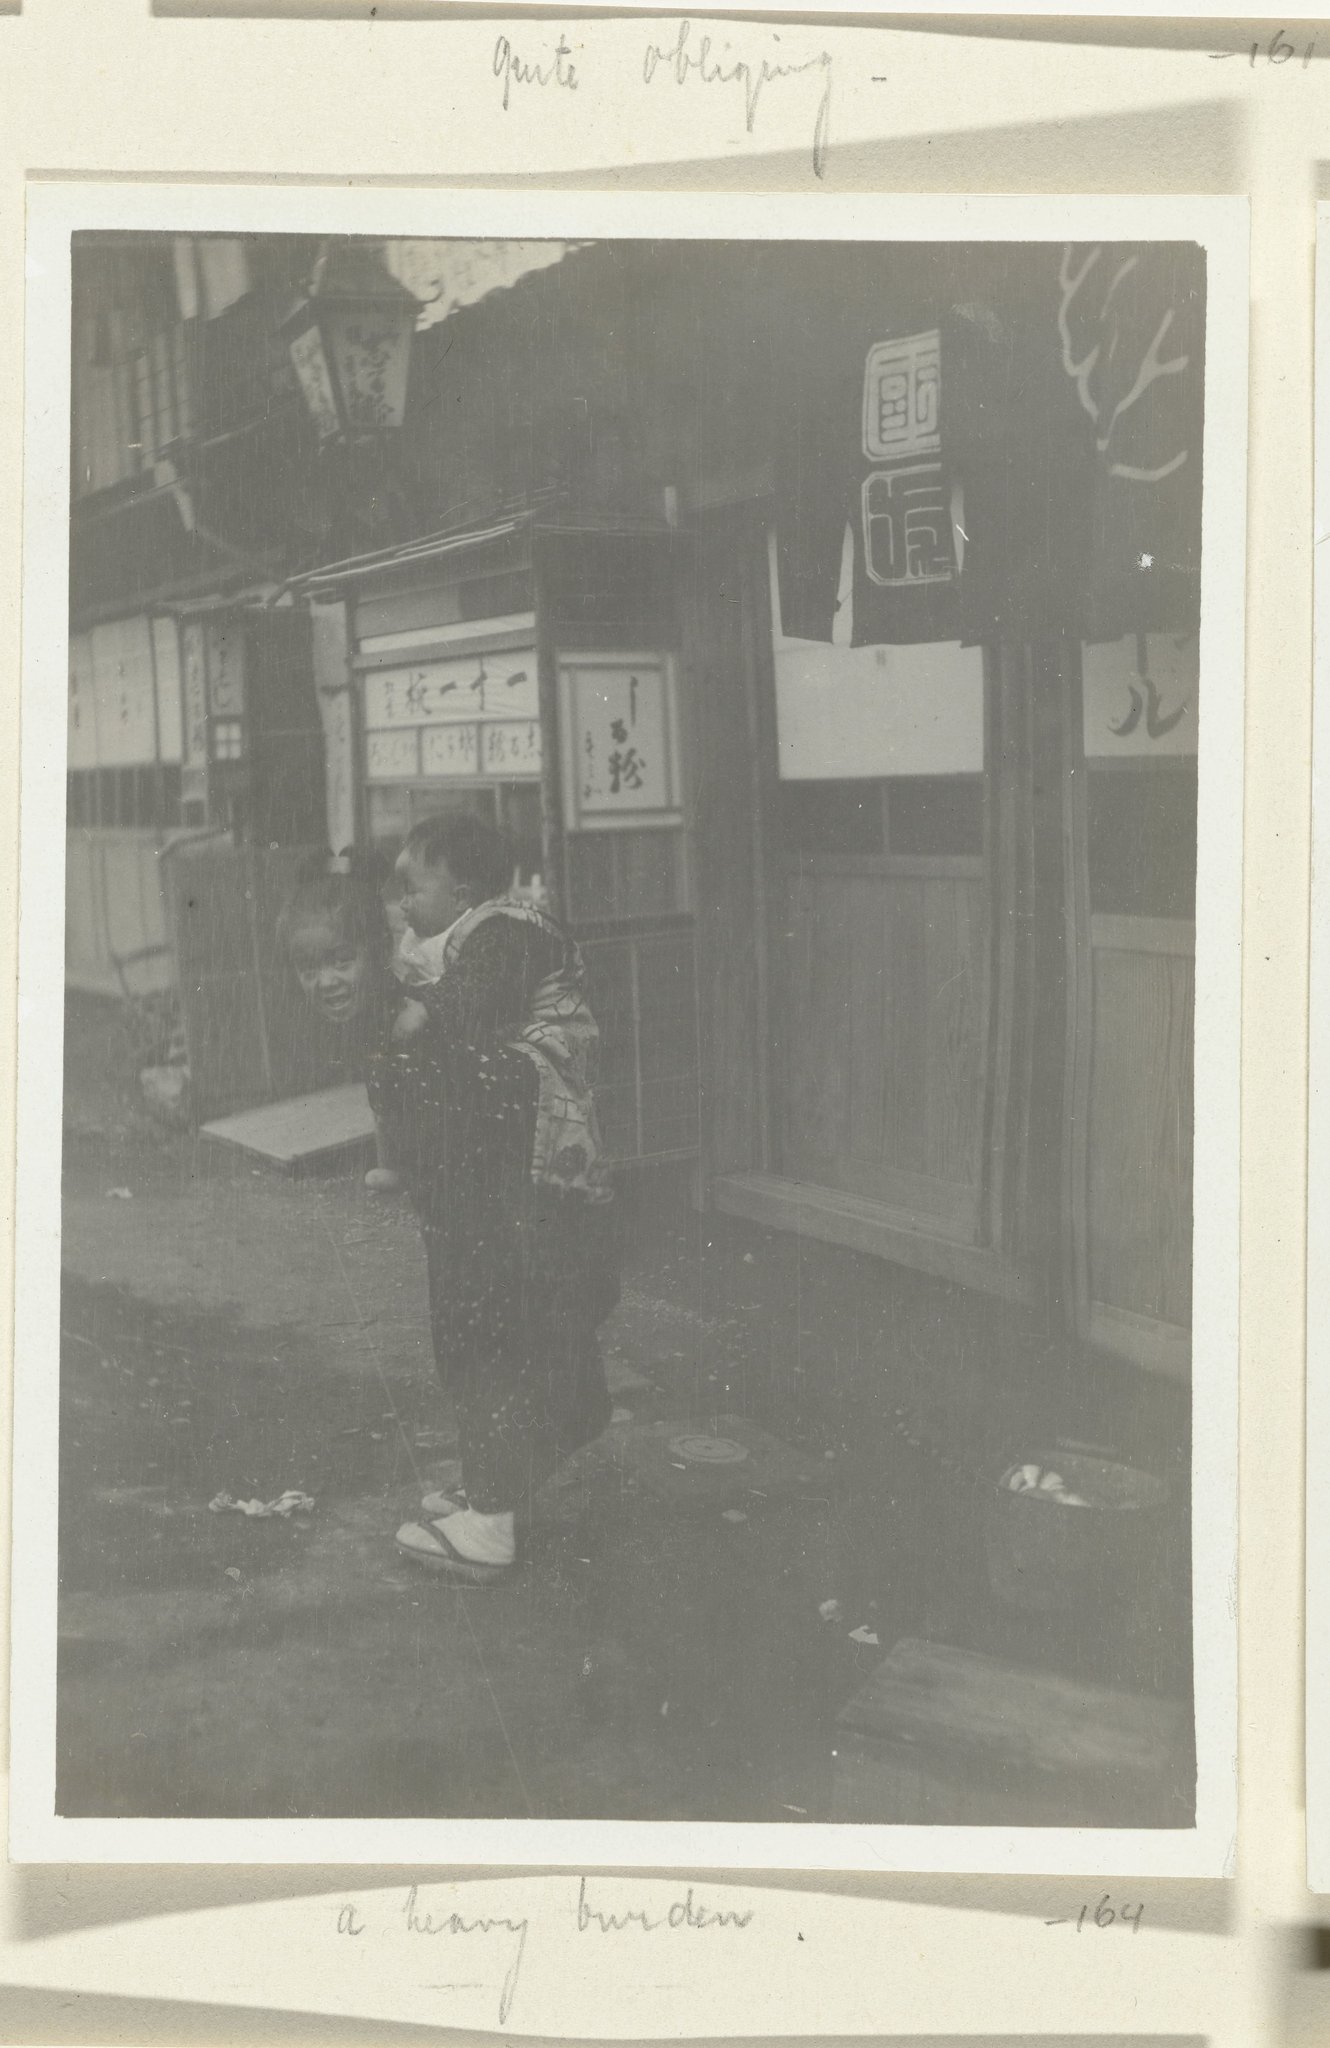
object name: photograph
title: A heavy burden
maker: geldolph adriaan kessler (dolph)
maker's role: fotograaf, industrieel, voetballer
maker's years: 1884-1945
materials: cardboard, photographic support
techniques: gelatin silver print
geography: japan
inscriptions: title: ‘a heavy burden’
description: Japans meisje in kimono met op haar rug een baby. Onderdeel van het fotoalbum van Dolph Kessler met opnamen die hij maakte tijdens zijn verblijf in Engeland en op een wereldreis die hij als secretaris van Henri Deterding (directeur Koninklijke Olie) ondernam naar Nederlands-Indië, Japan, China en de Verenigde Staten, tussen 1906 en 1908.